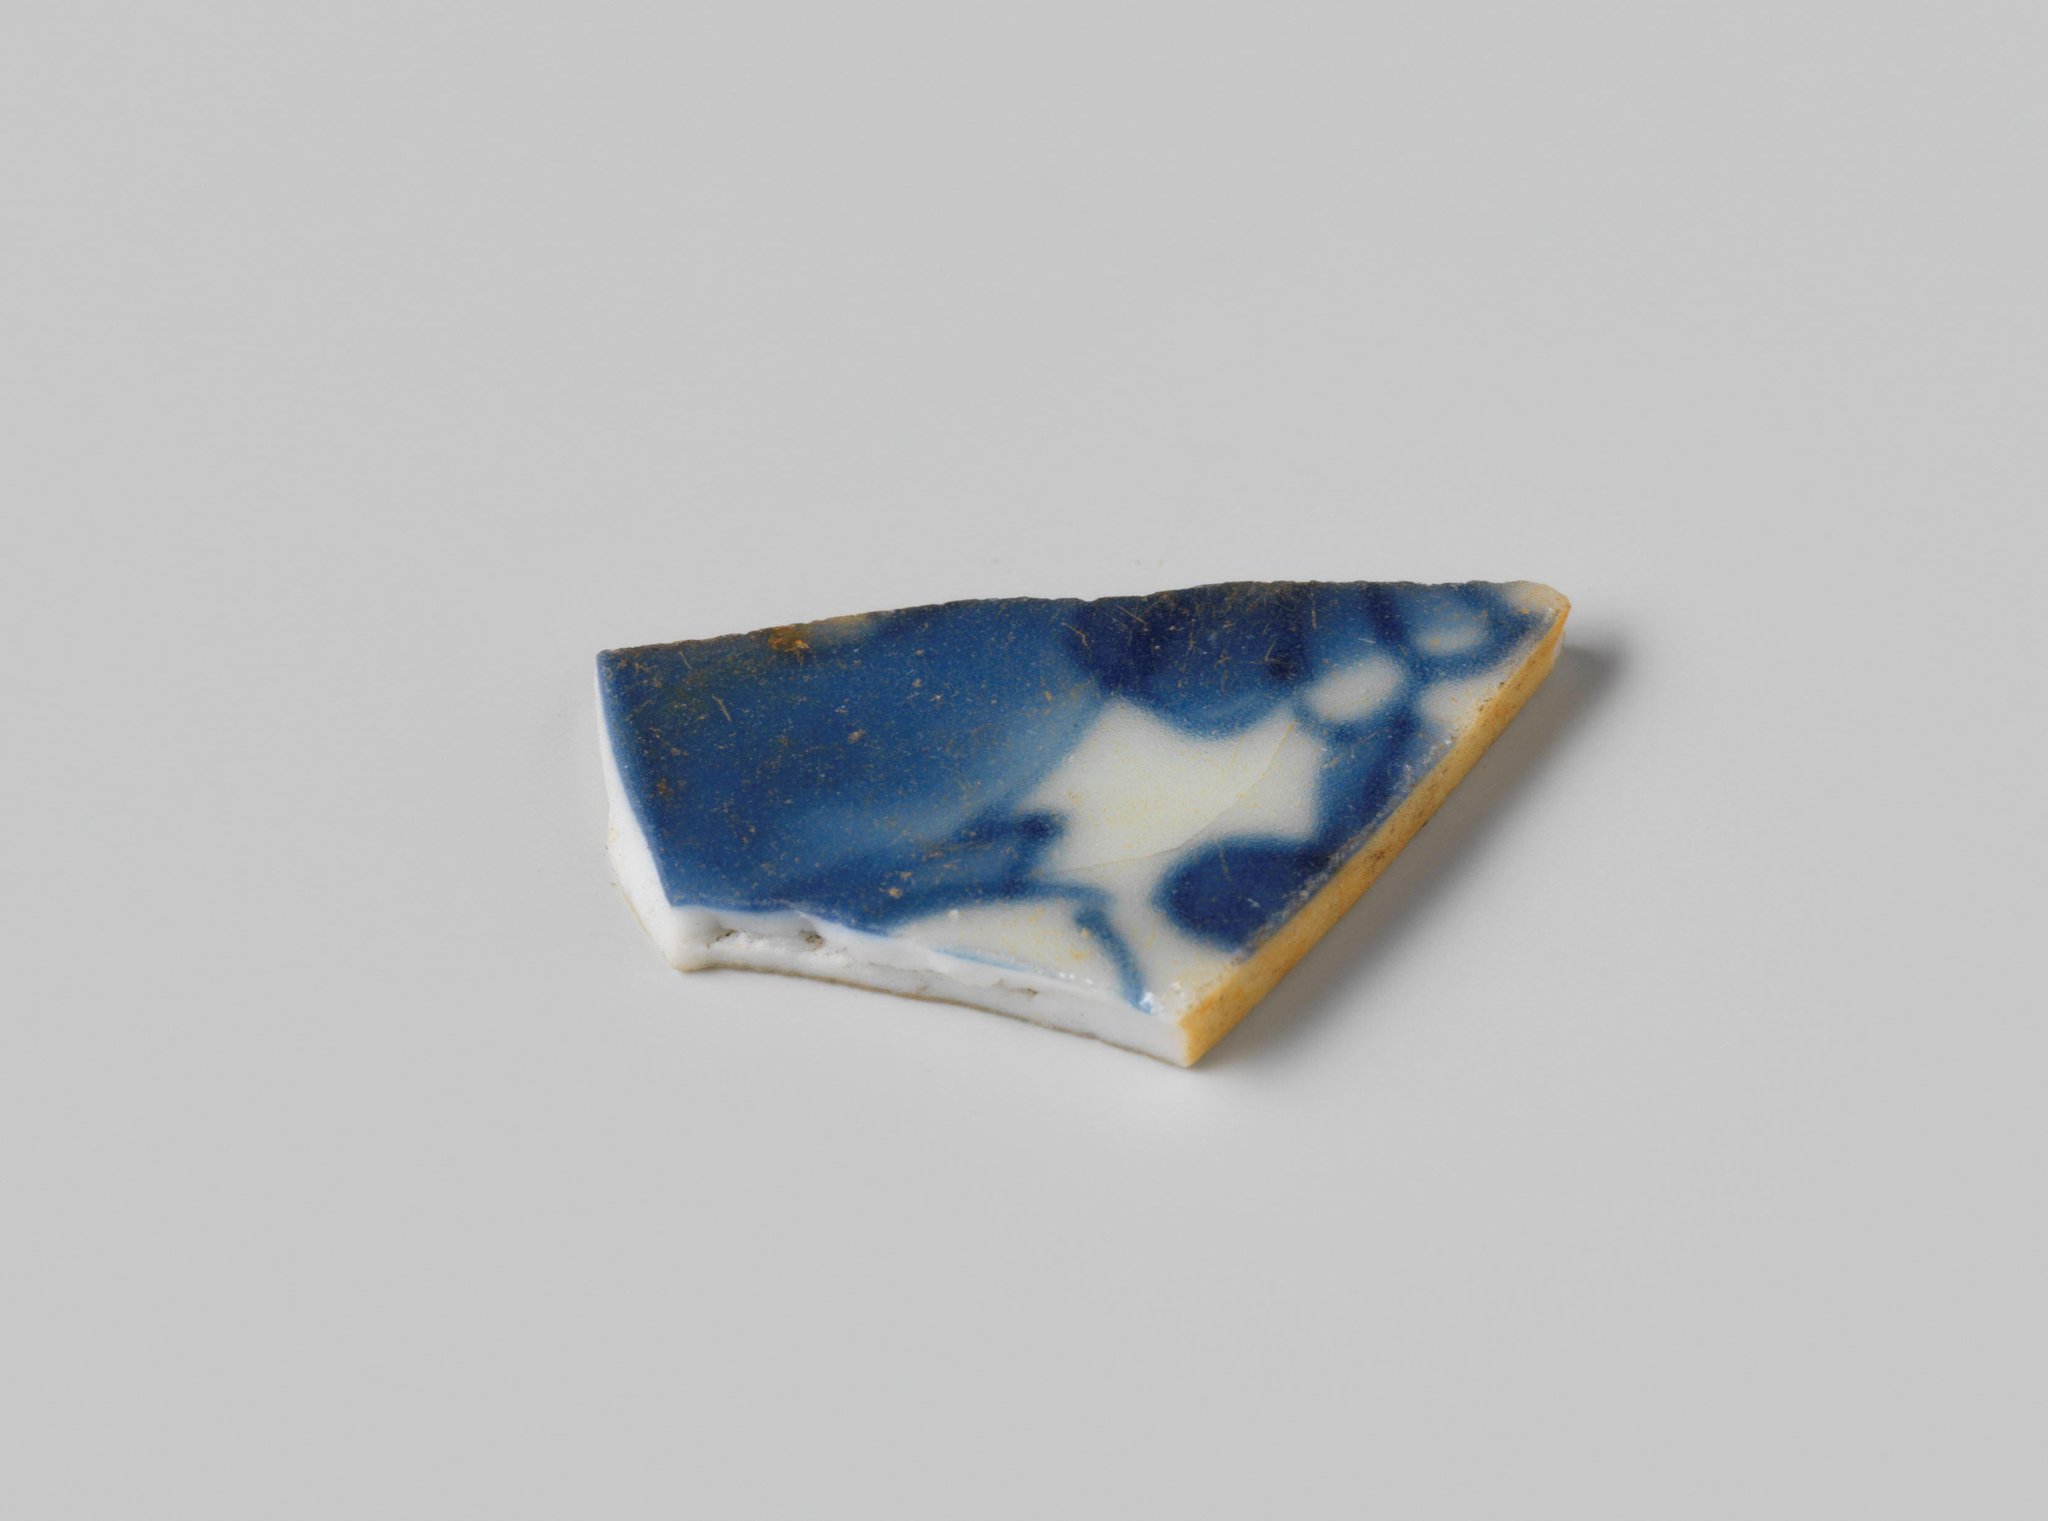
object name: sherd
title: Porseleinen scherf uit het wrak van de Oost-Indiëvaarder Hollandia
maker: Anonymous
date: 1700-1743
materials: porcelain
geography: netherlands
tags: verenigde oostindische compagnie, hollandia (schip), annet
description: Porcelain, fragm of body, interior blank, exterior decorated, with join of handle.